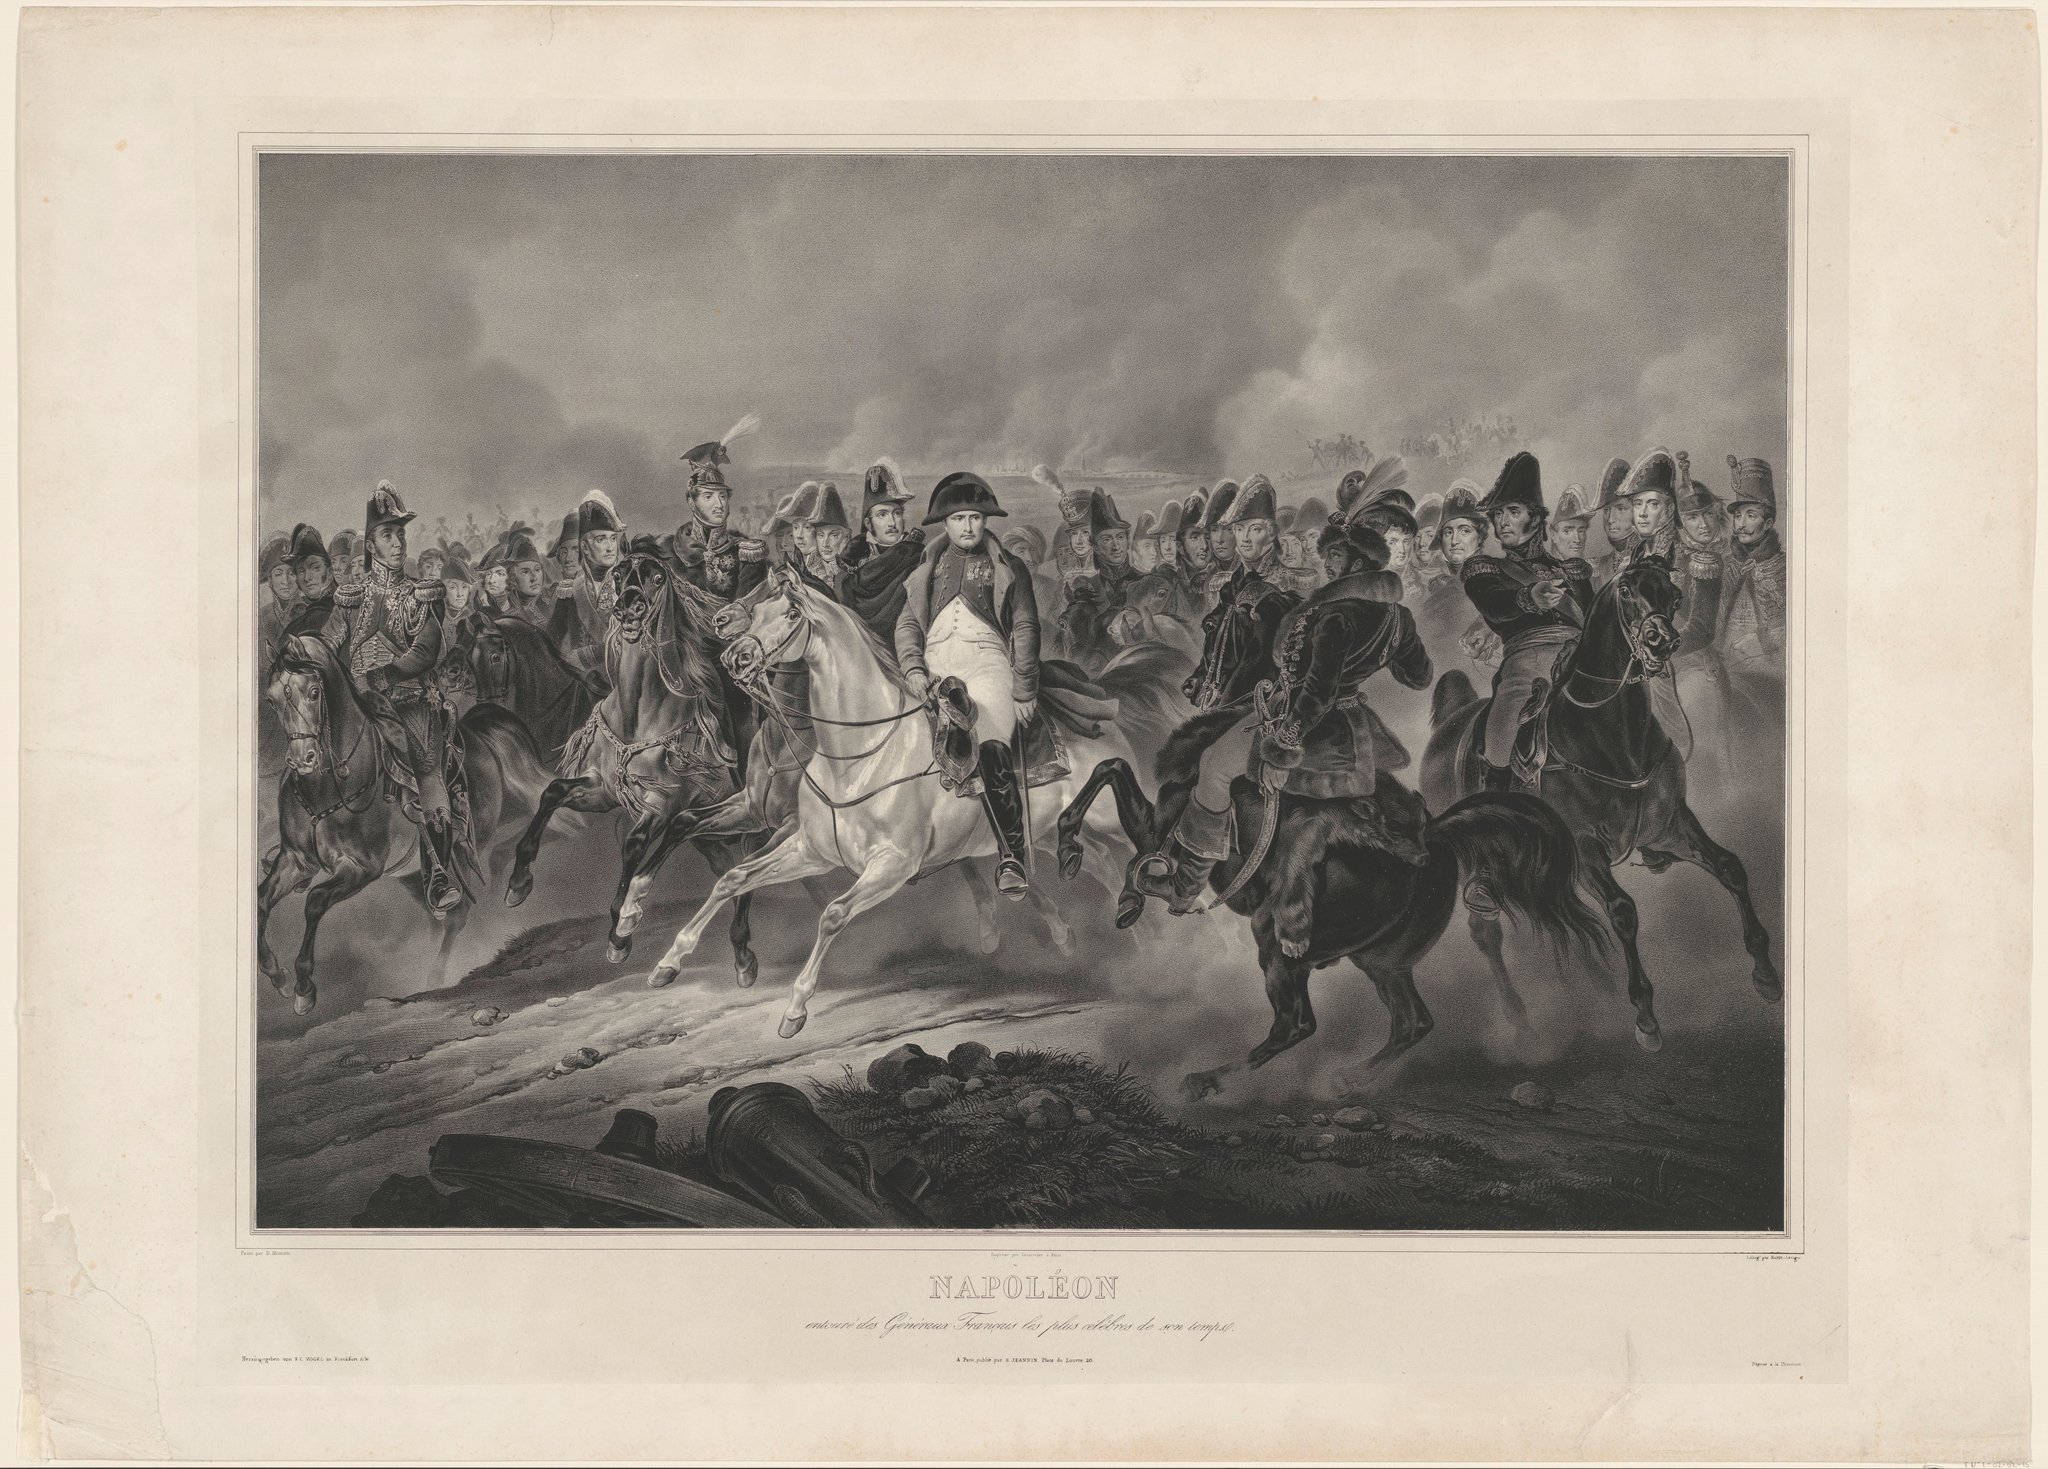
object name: print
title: Napoleon en generaals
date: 1830-1852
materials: paper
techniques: lithograph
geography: paris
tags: napoleon i (emperor of the french), army 'en route', commander-in-chief, general, marshal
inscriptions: collector's mark: Lugt 2228